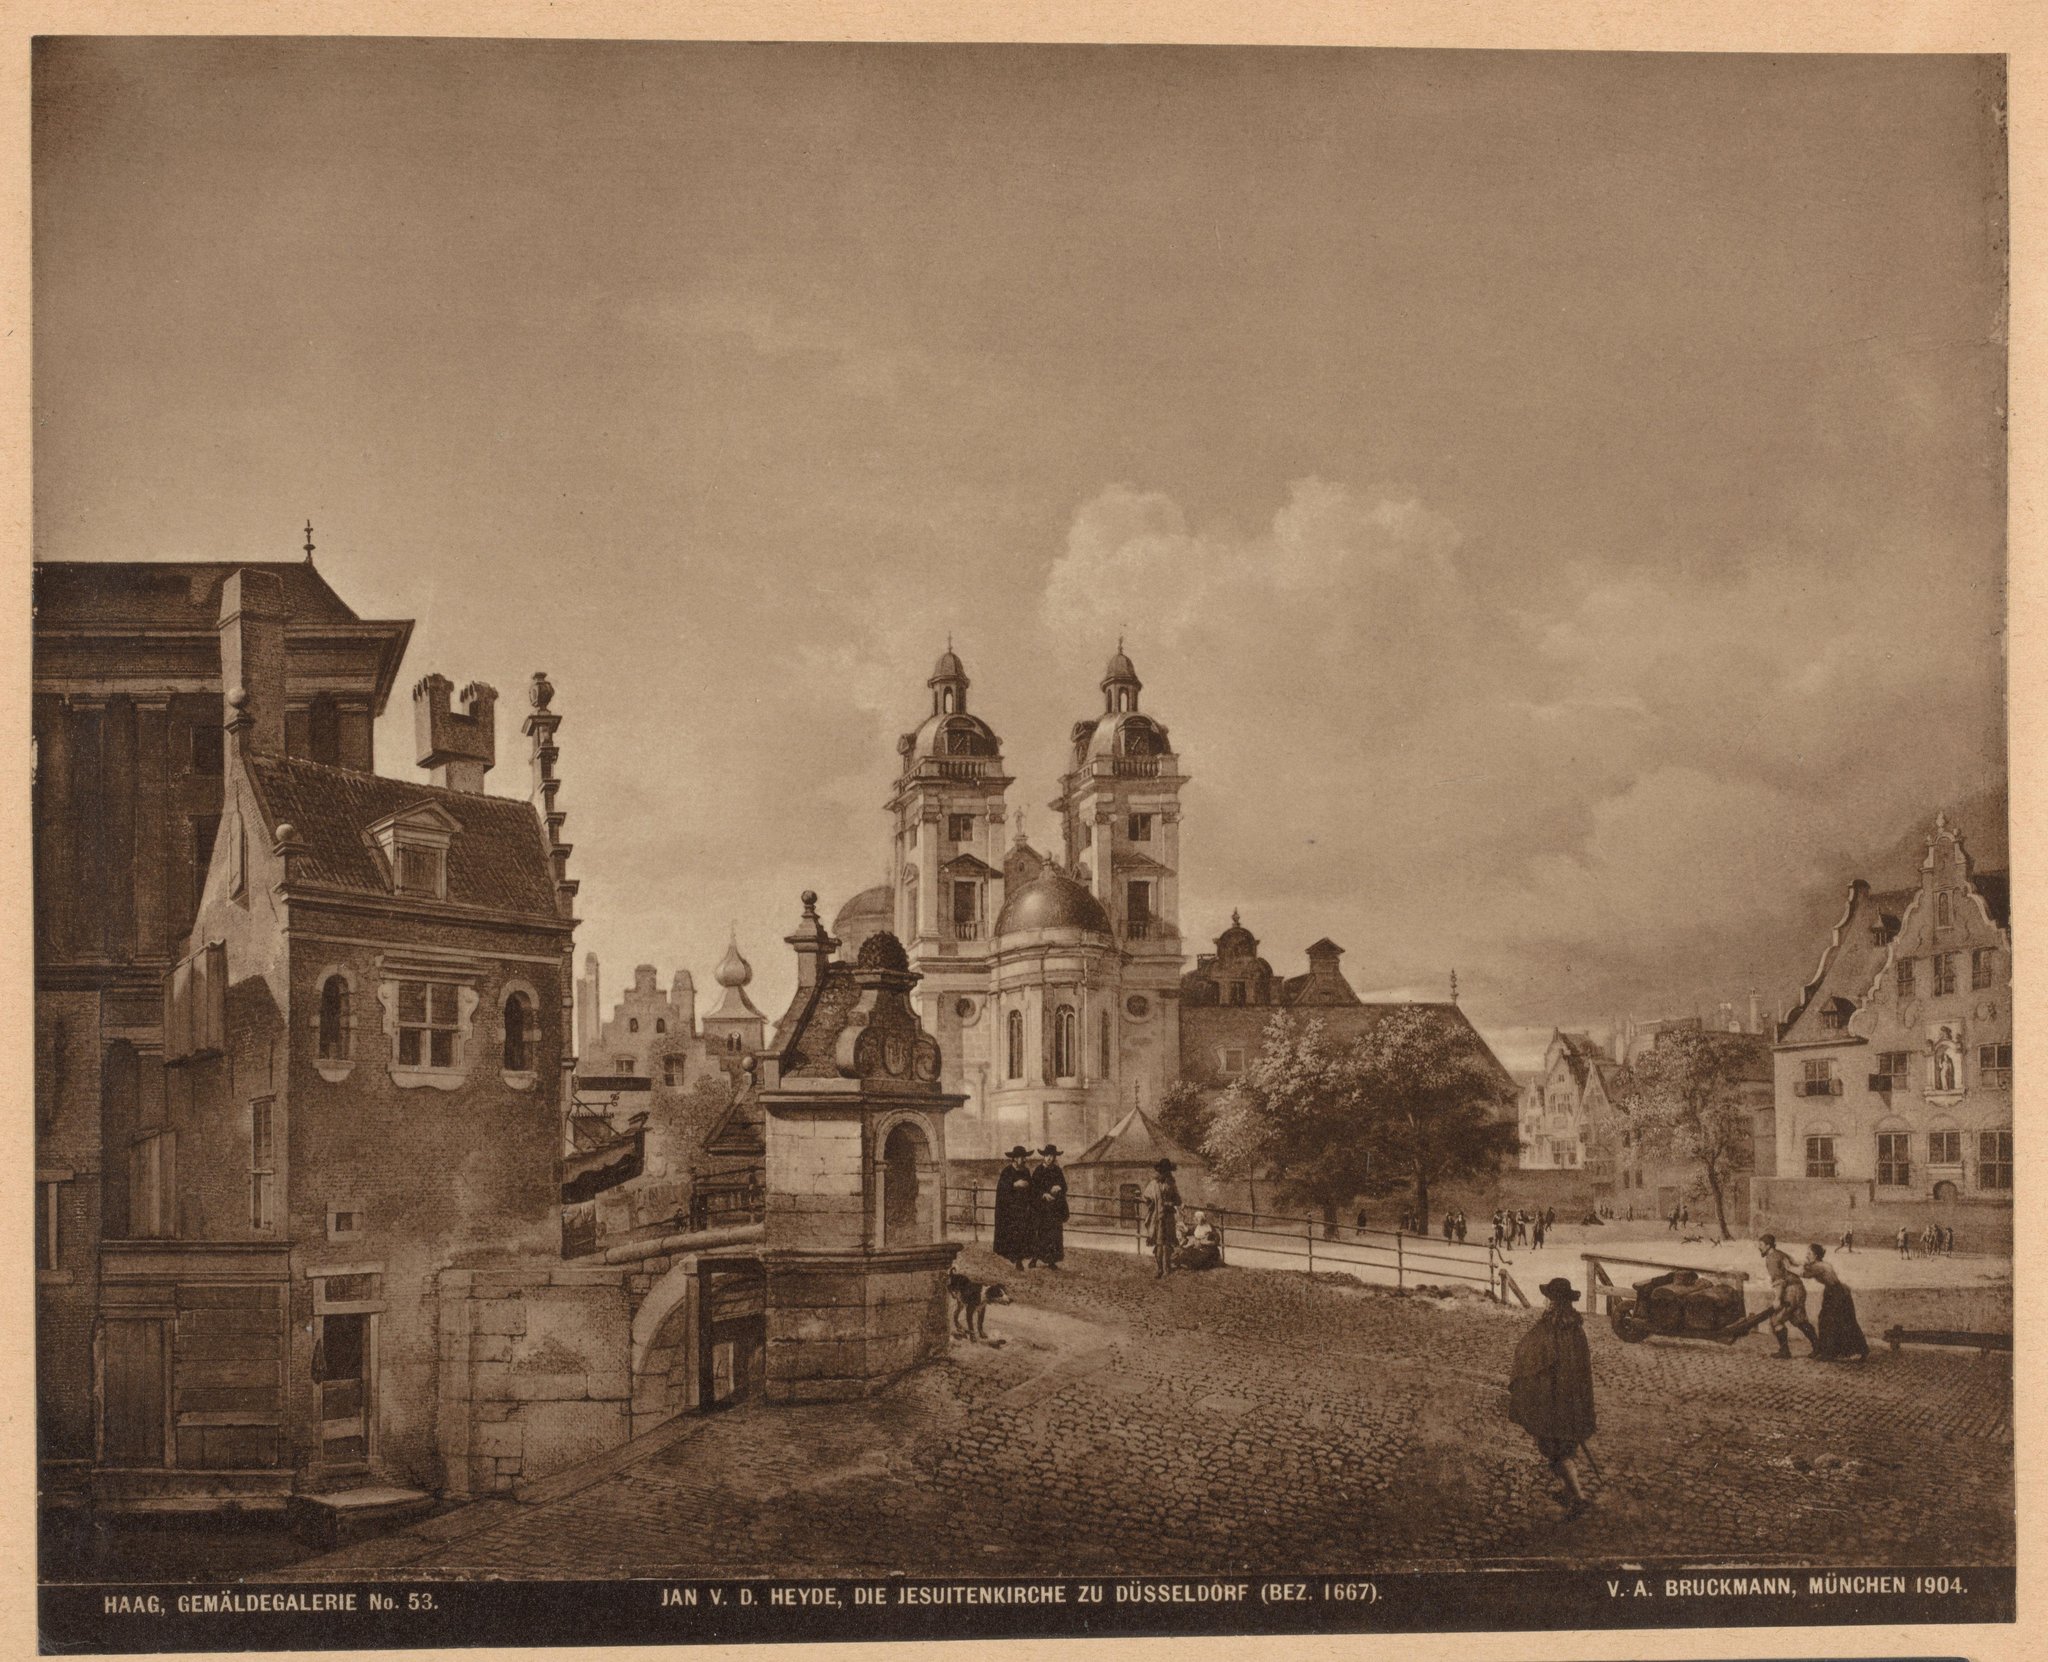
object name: photomechanical print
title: Jan v.d. Heyde, Die Jesuitenkirche zu Düsseldorf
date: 1904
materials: paper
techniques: photograph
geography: munich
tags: church (exterior), picture, painting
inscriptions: inscription: ‘Haag, Gemäldegalerie No. 53. Jan v.d. Heyde, Die Jesuitenkirche zu Düsseldorf (bez. 1667) V.A. Bruckmann, München 1904.’